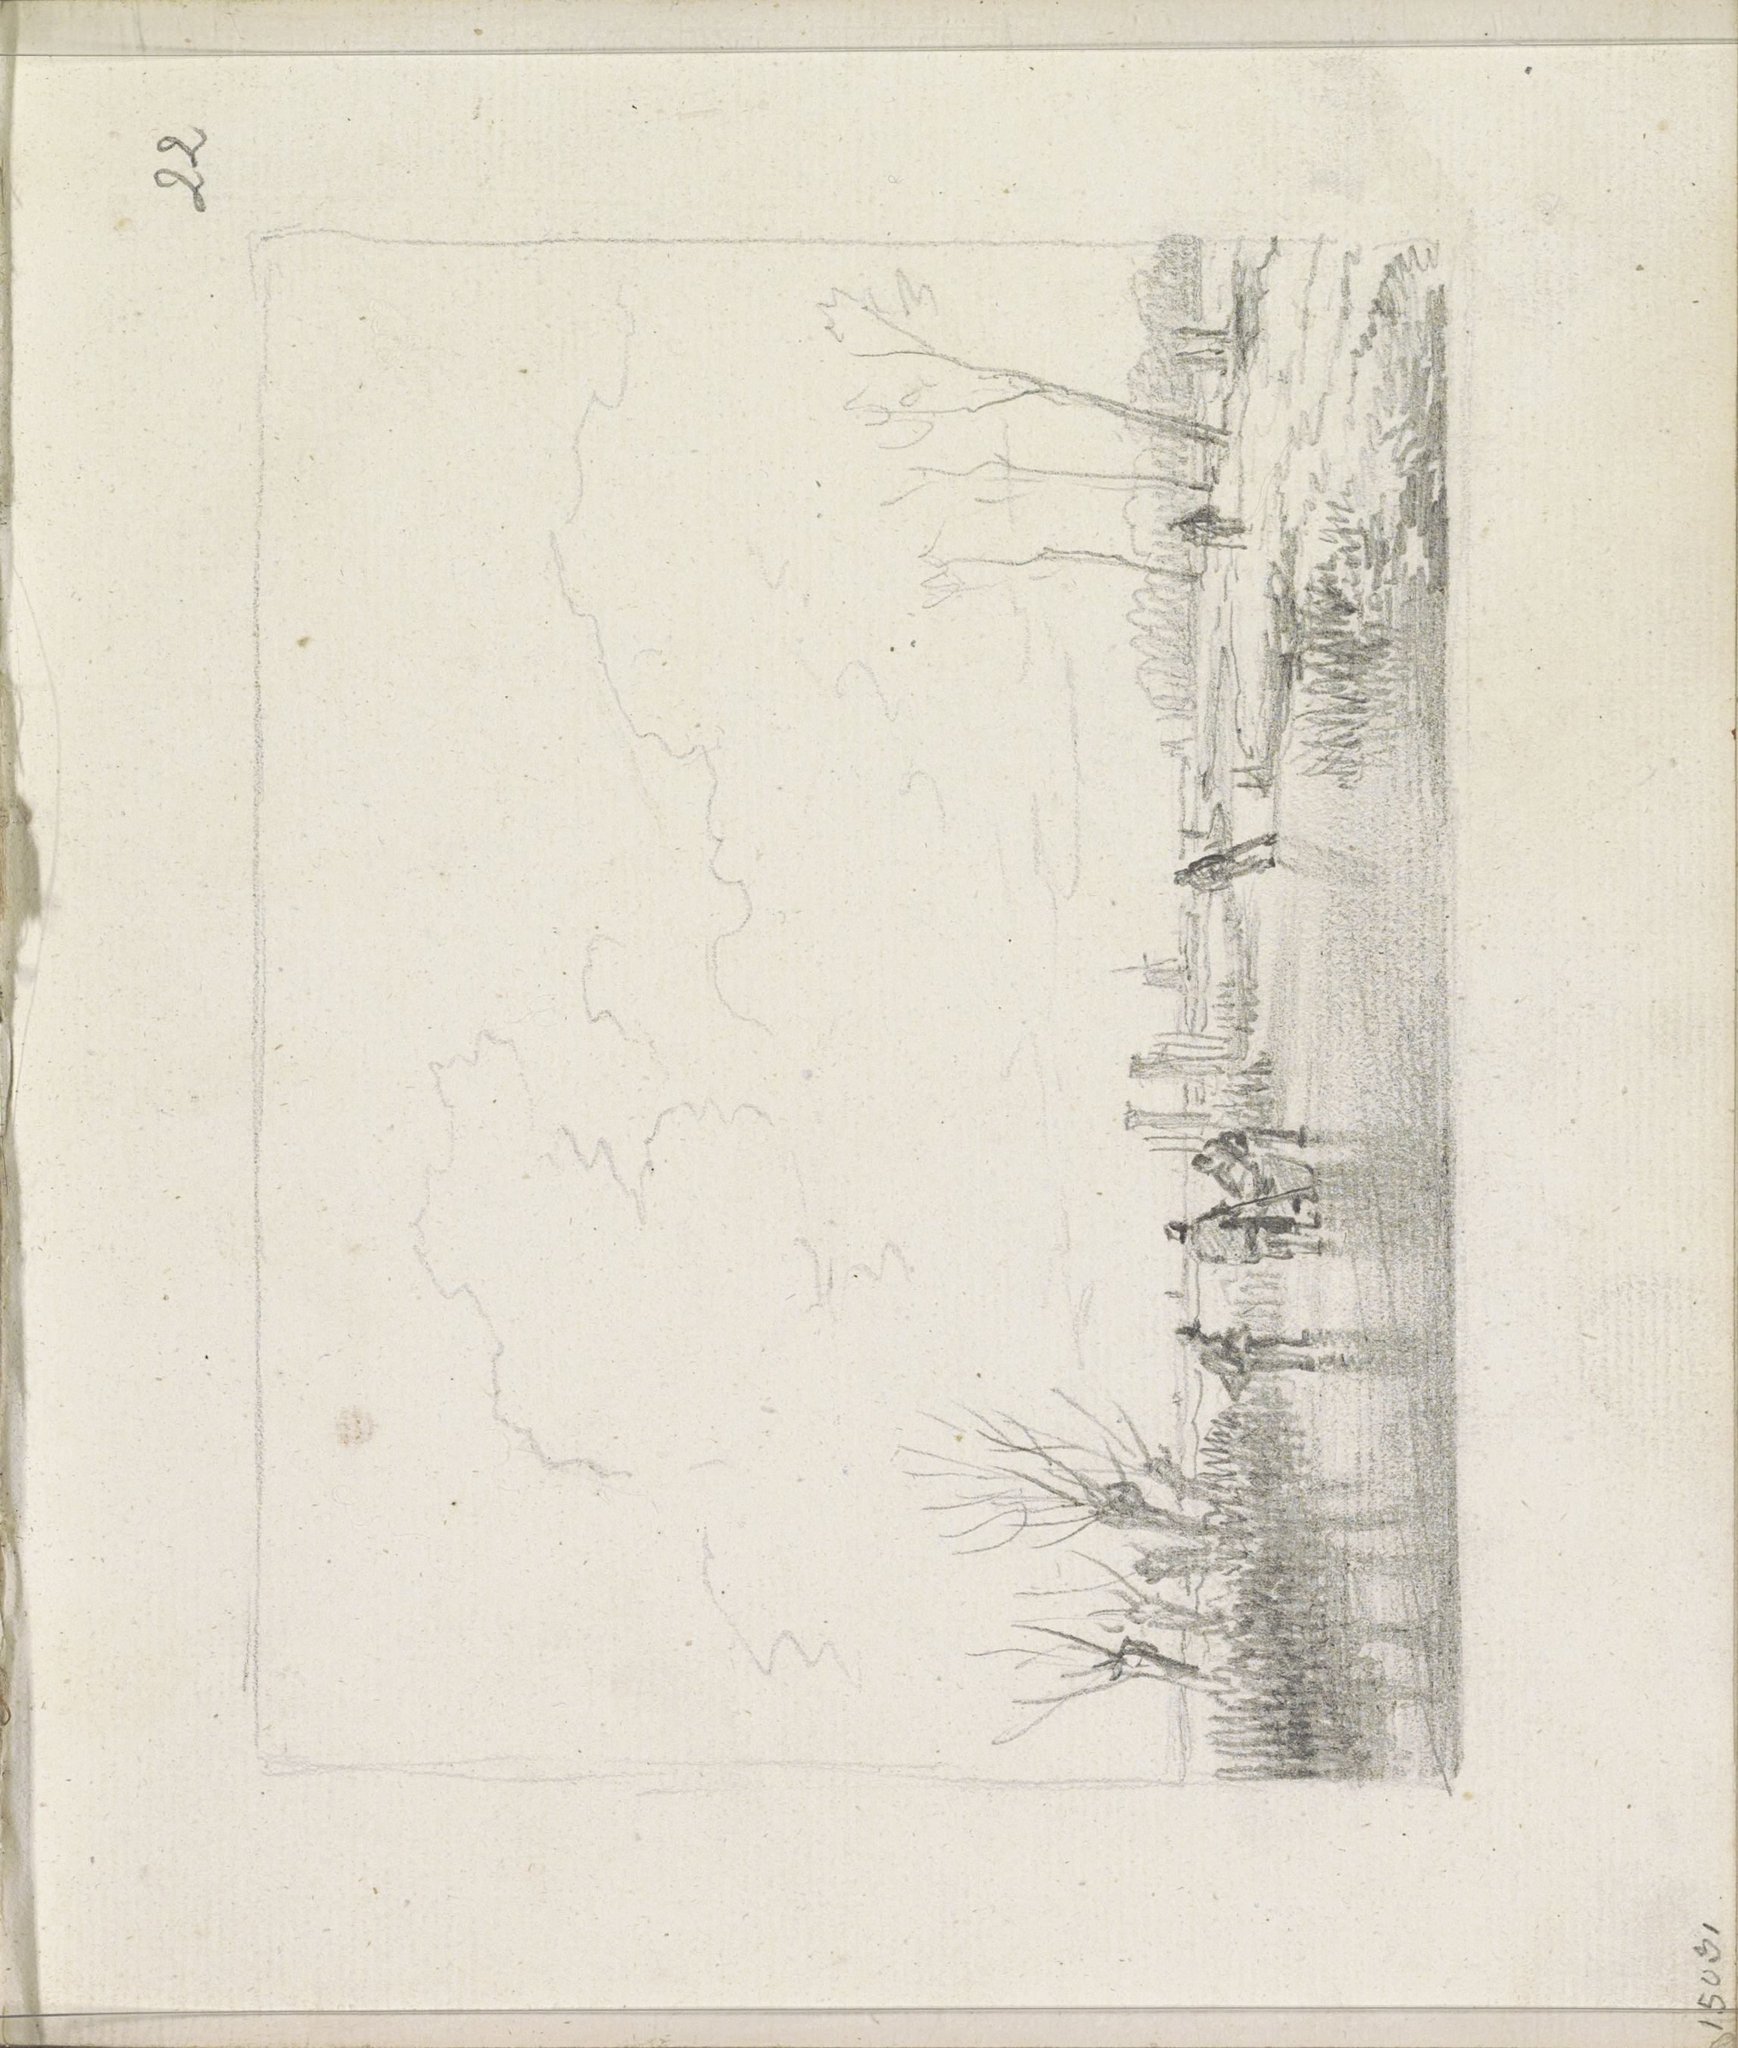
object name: sketchbook leaf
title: Winterlandschap met schaatsers op een bevroren vaart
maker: andreas schelfhout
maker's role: draughtsman, painter, print maker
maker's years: 1787-1870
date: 1825-1829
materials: paper, pencil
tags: frost, freezing weather, skates (winter sports)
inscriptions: number: ‘22/ 15031’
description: Blad 36 recto uit een schetsboek met 95 bladen.